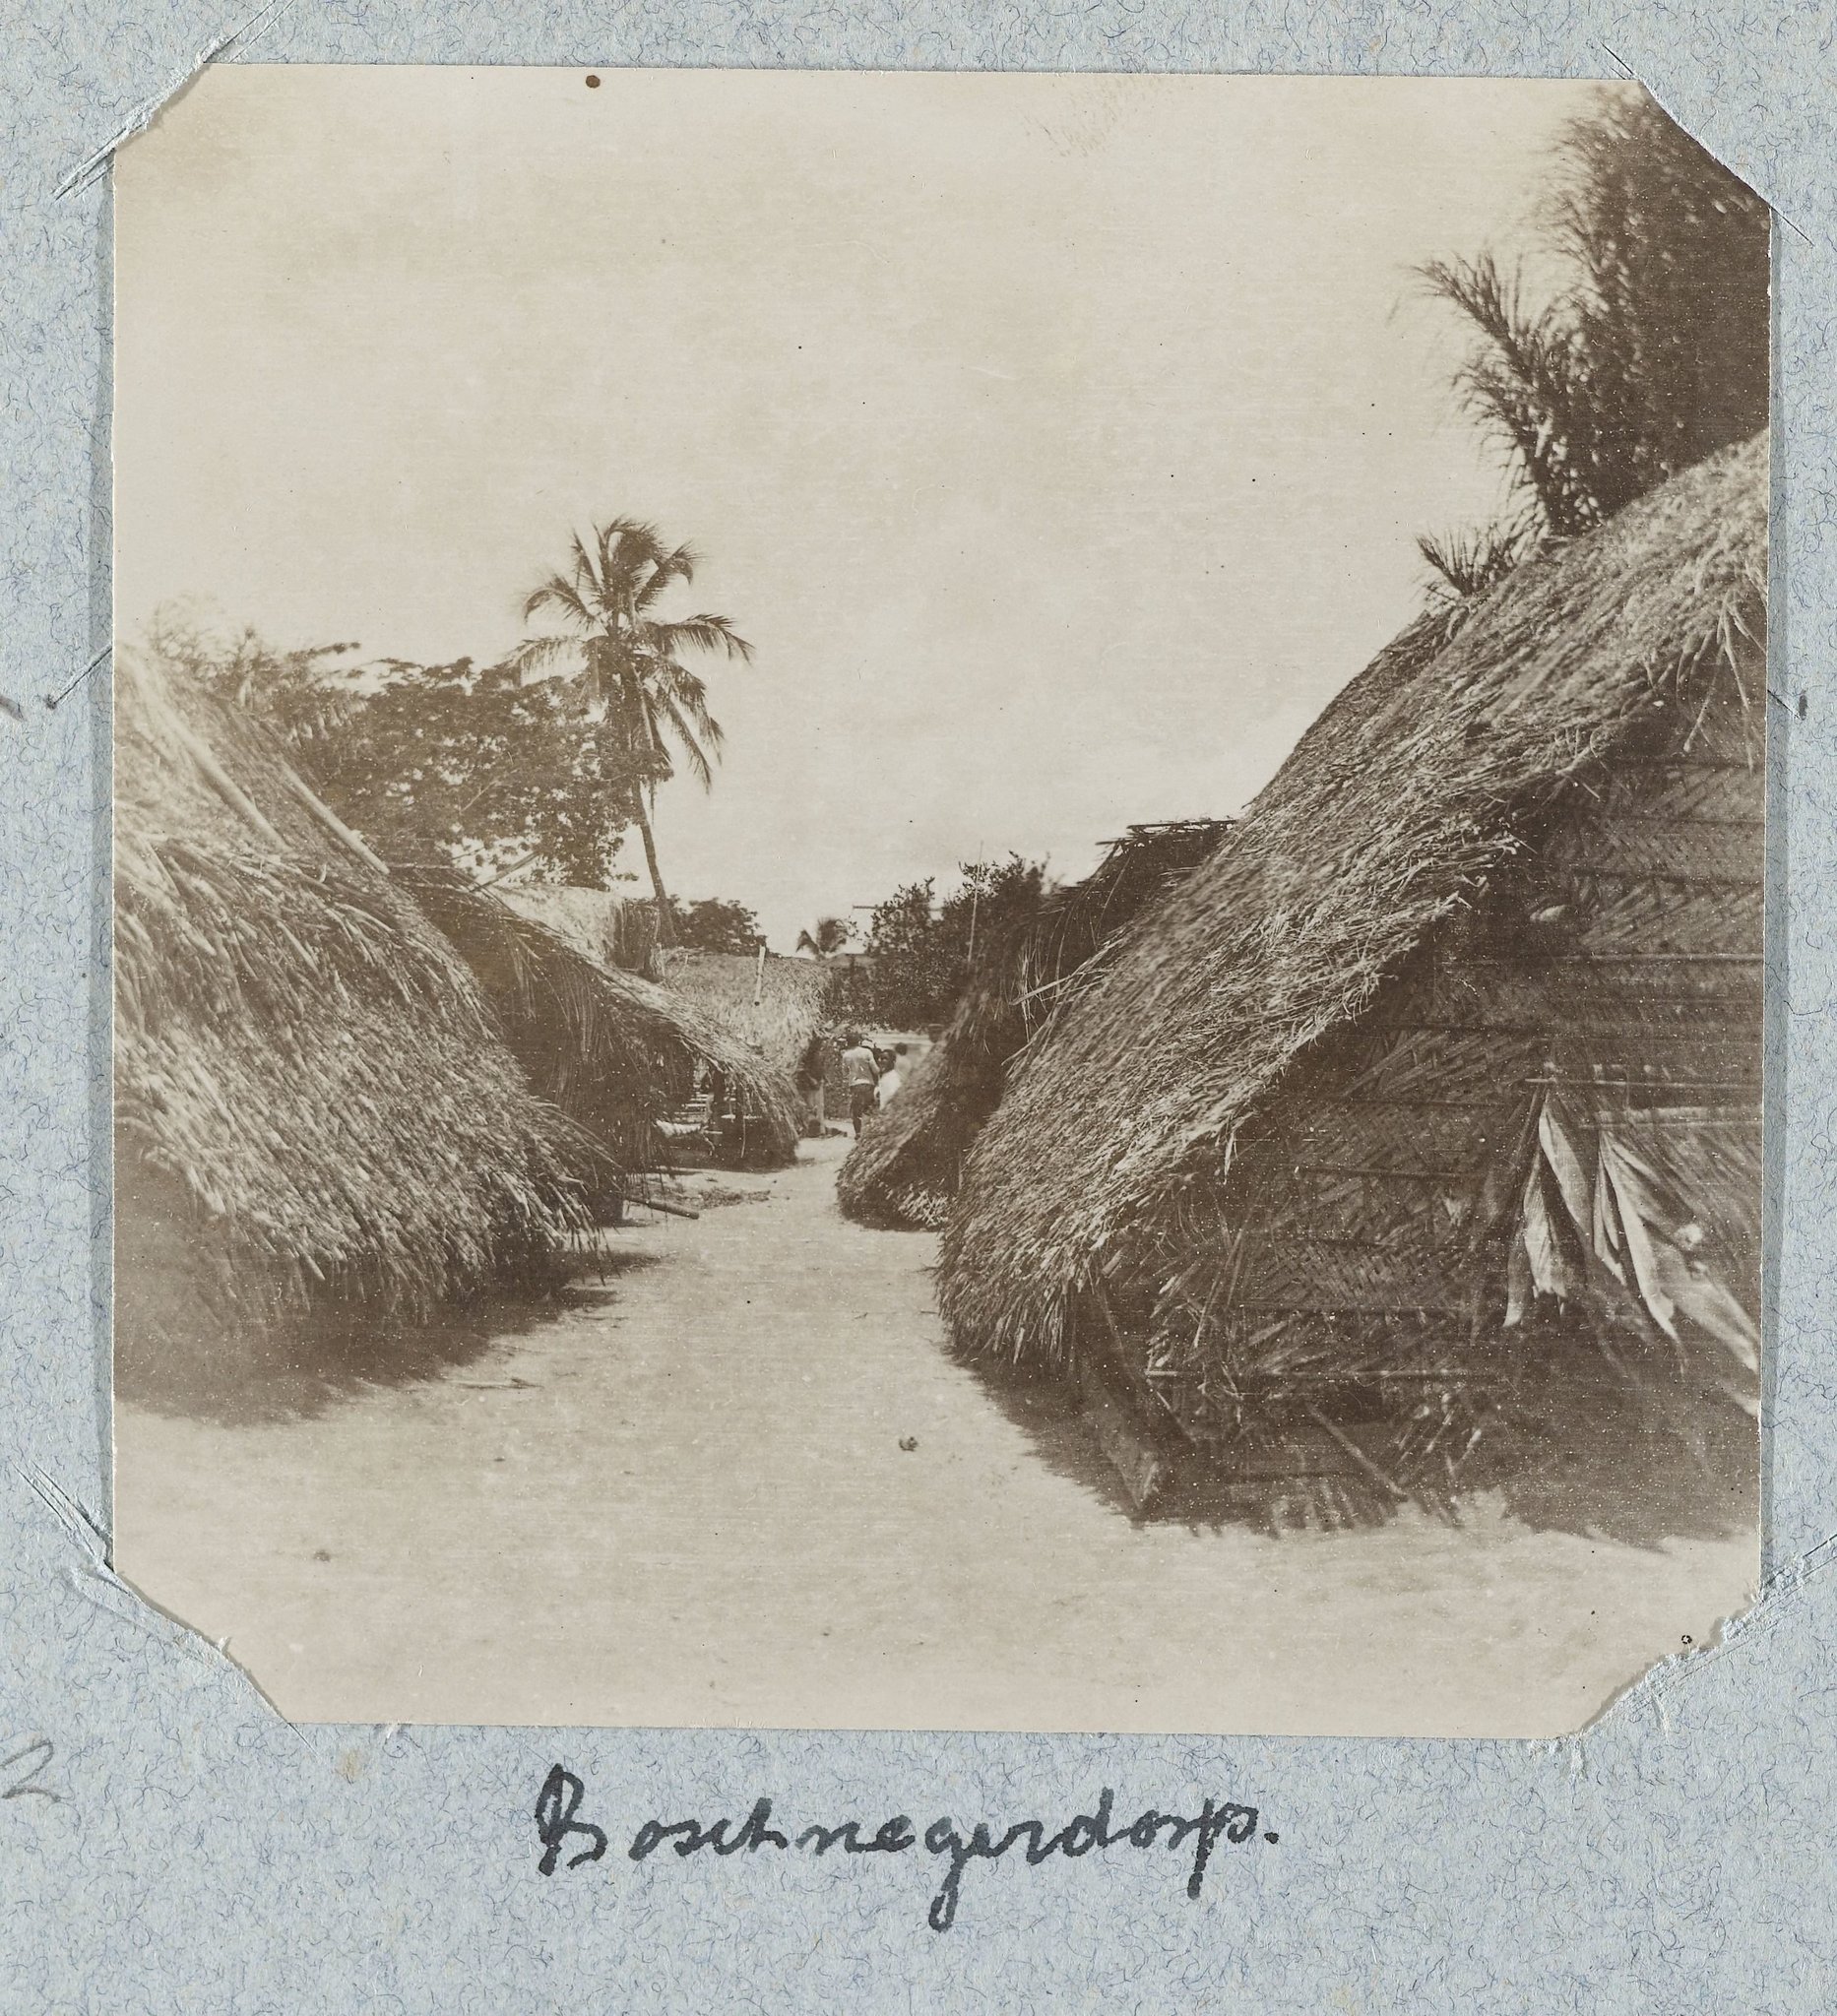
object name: photograph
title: Boschnegerdorp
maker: théodore van lelyveld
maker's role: painter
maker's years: 1867-1954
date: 1808-1897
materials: photographic support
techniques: collodion silver print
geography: suriname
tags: public road in village (+ city(-scape) with figures, staffage)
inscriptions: inscription: ‘Boschnegerdorp’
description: Gezicht op een dorp van bosnegers, waarschijnlijk Albina in augustus 1897. Fotoafdruk in een fotoalbum van Théodore van Lelyveld over Suriname uit 1895-1898.